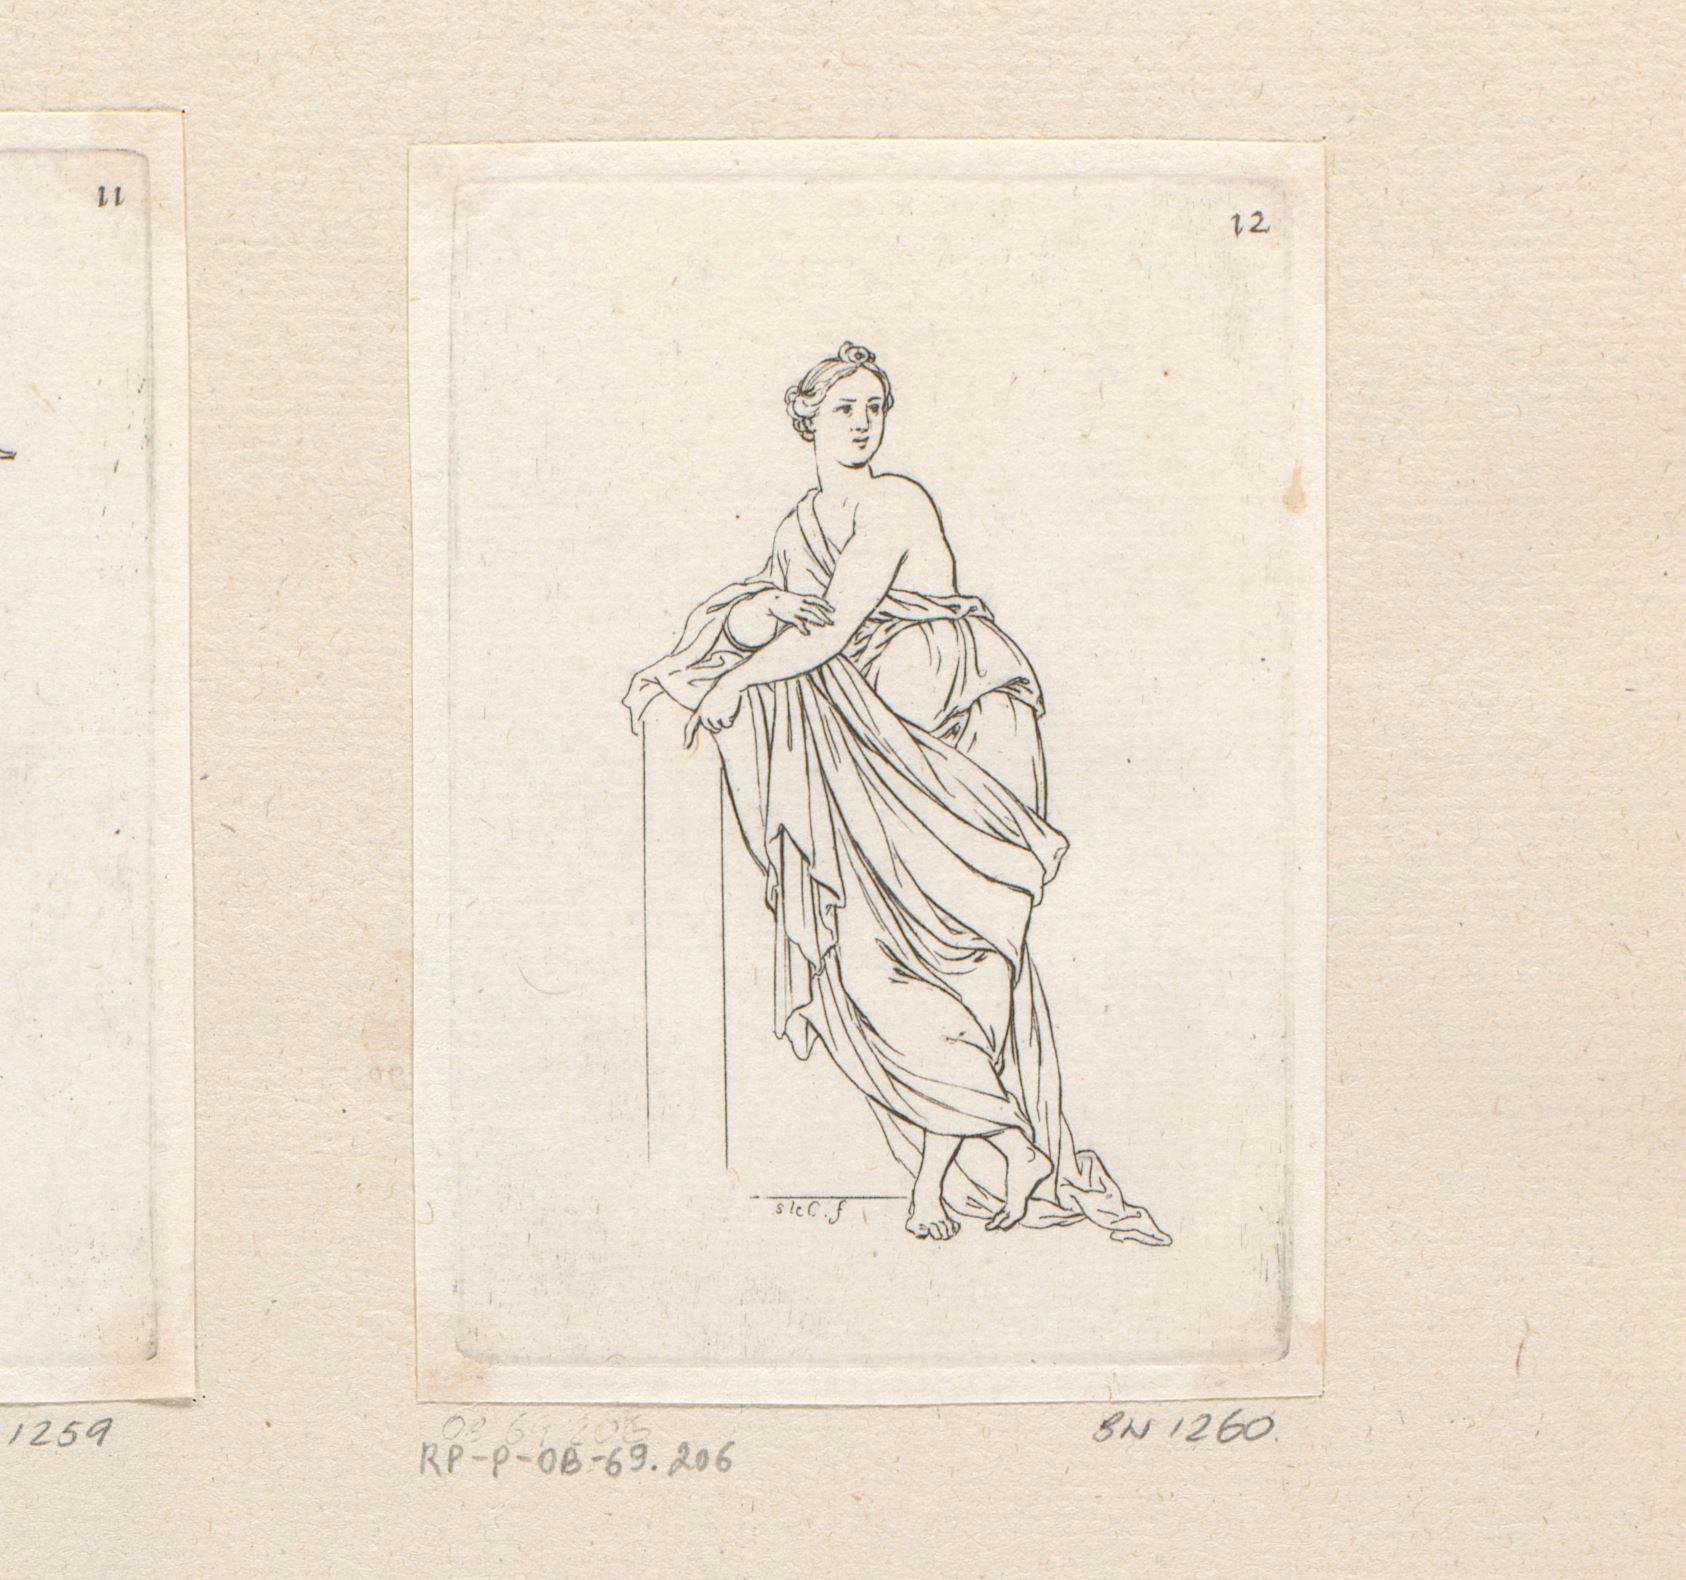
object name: print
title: Vrouw met ontblote linkerschouder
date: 1706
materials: paper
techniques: etching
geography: paris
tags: adult woman